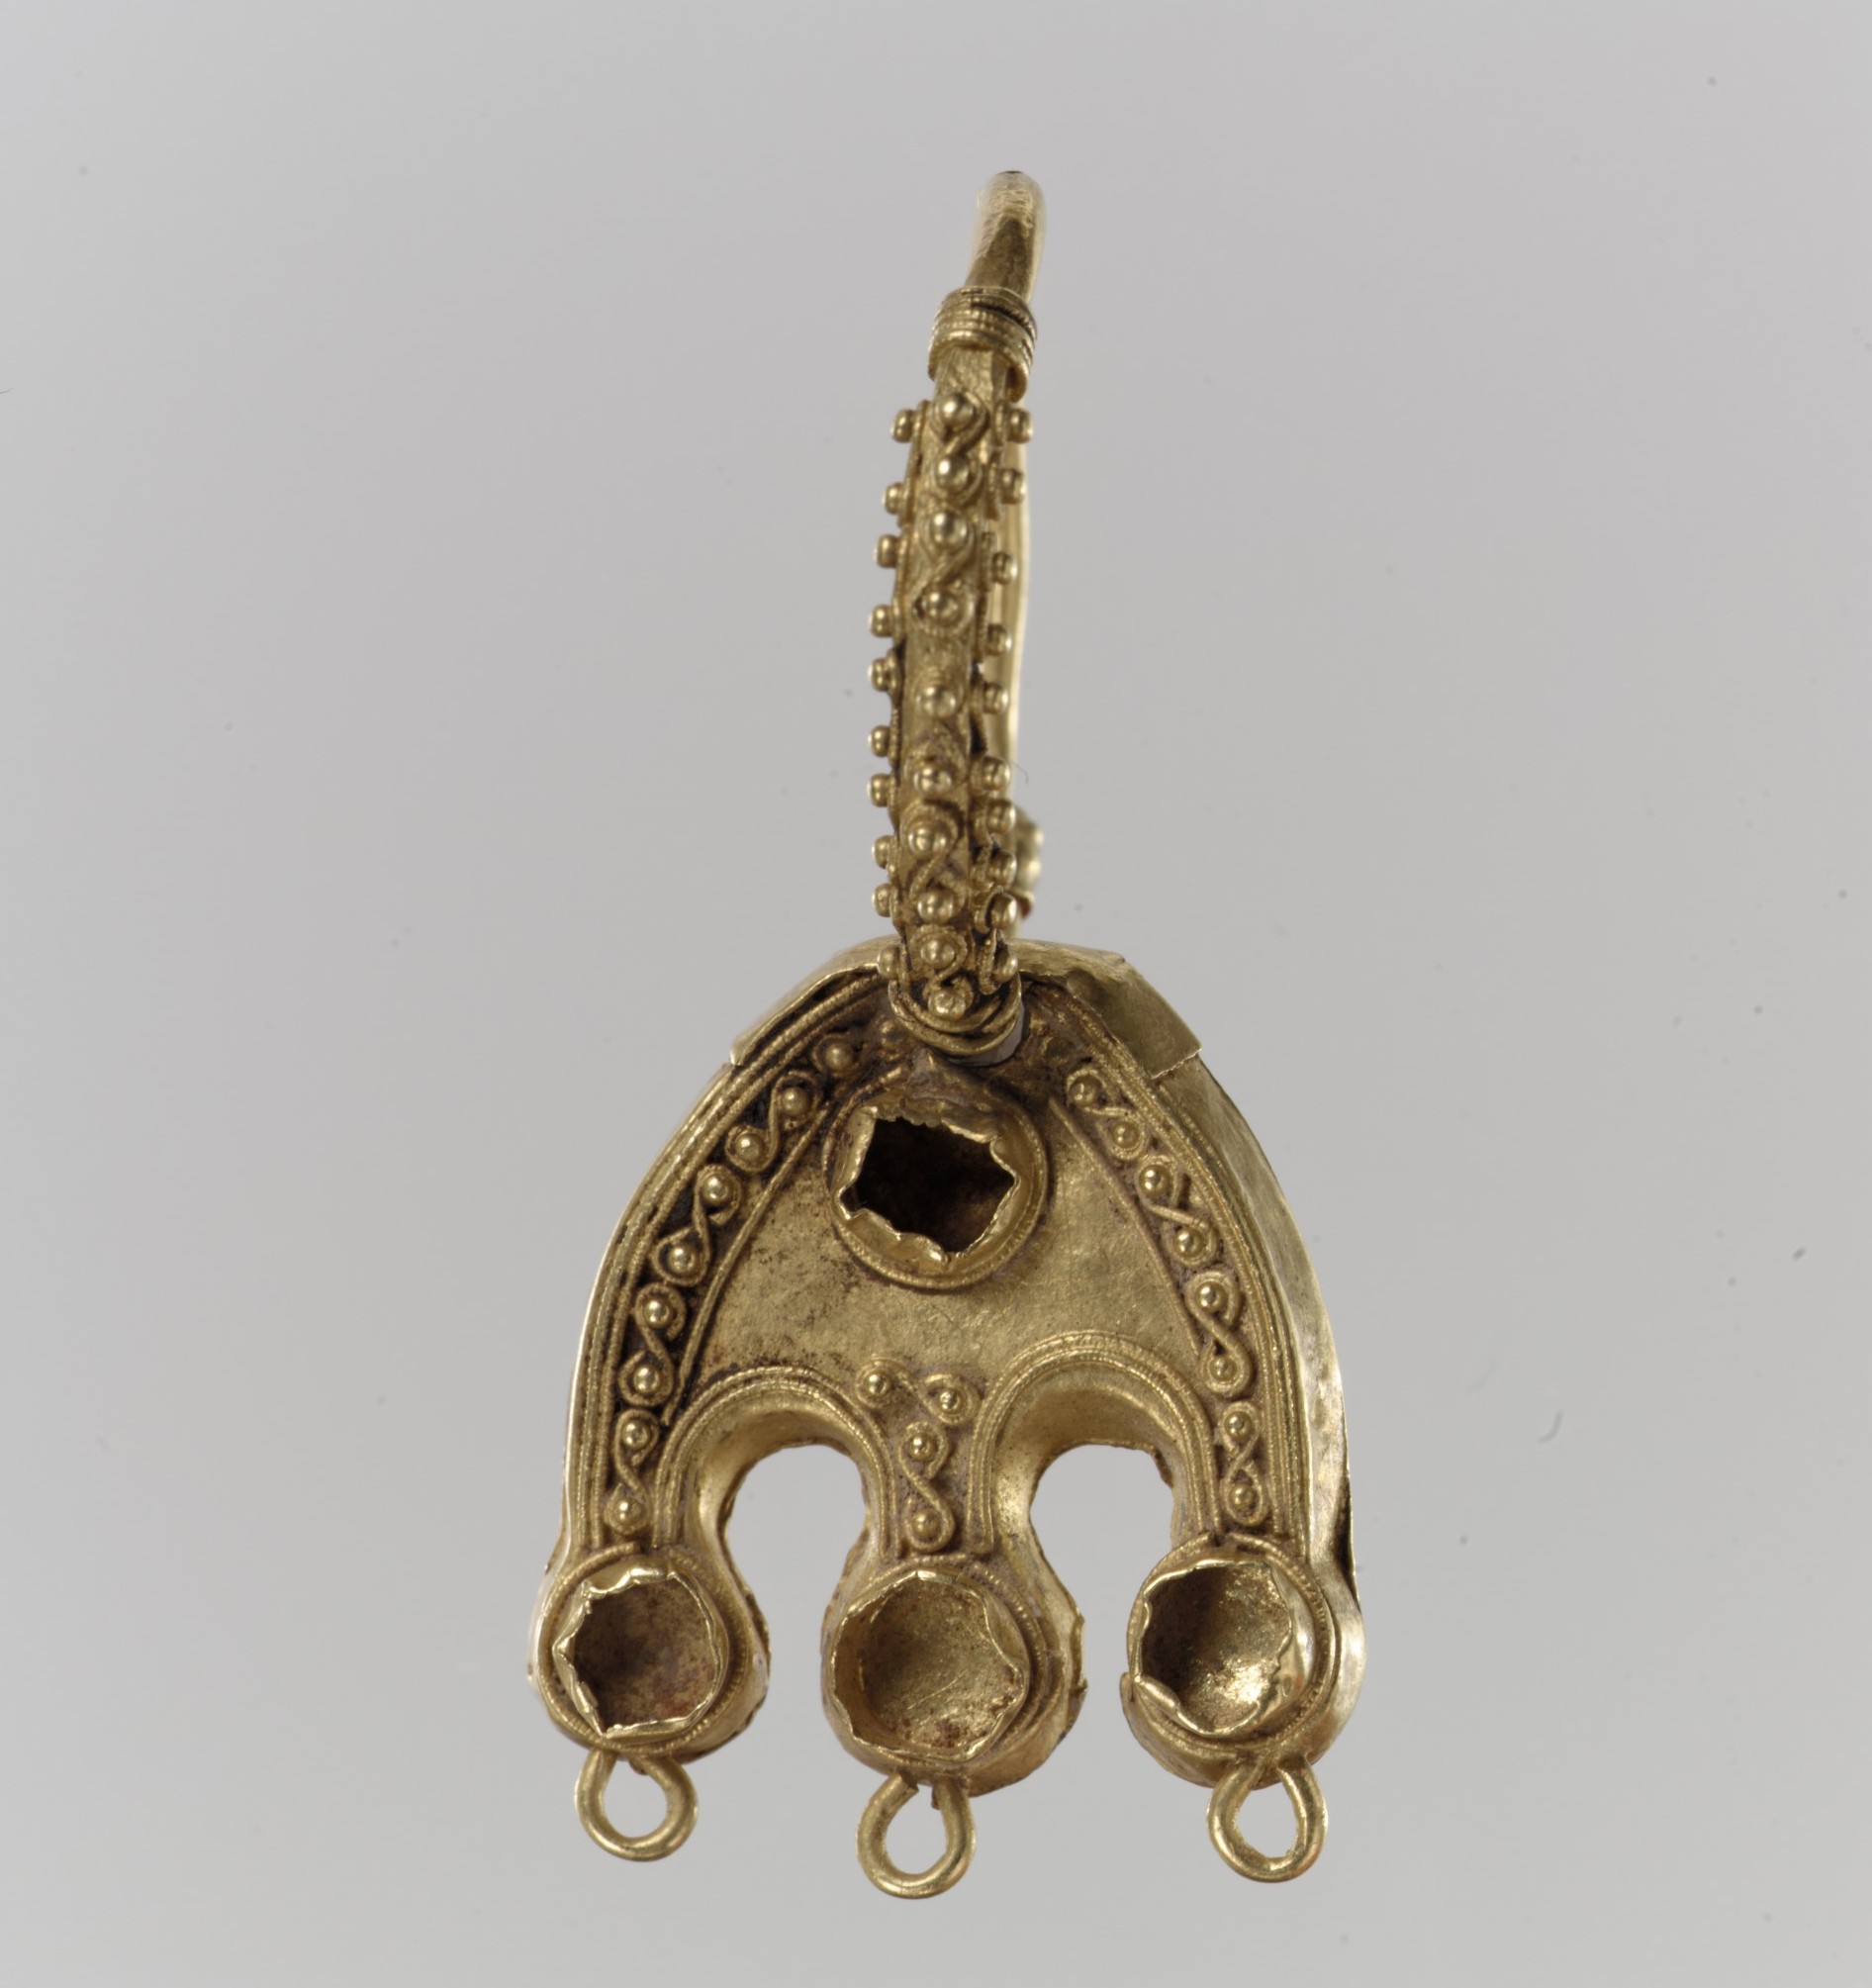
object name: earring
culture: byzantine or langobardic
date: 501-700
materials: gold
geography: italy